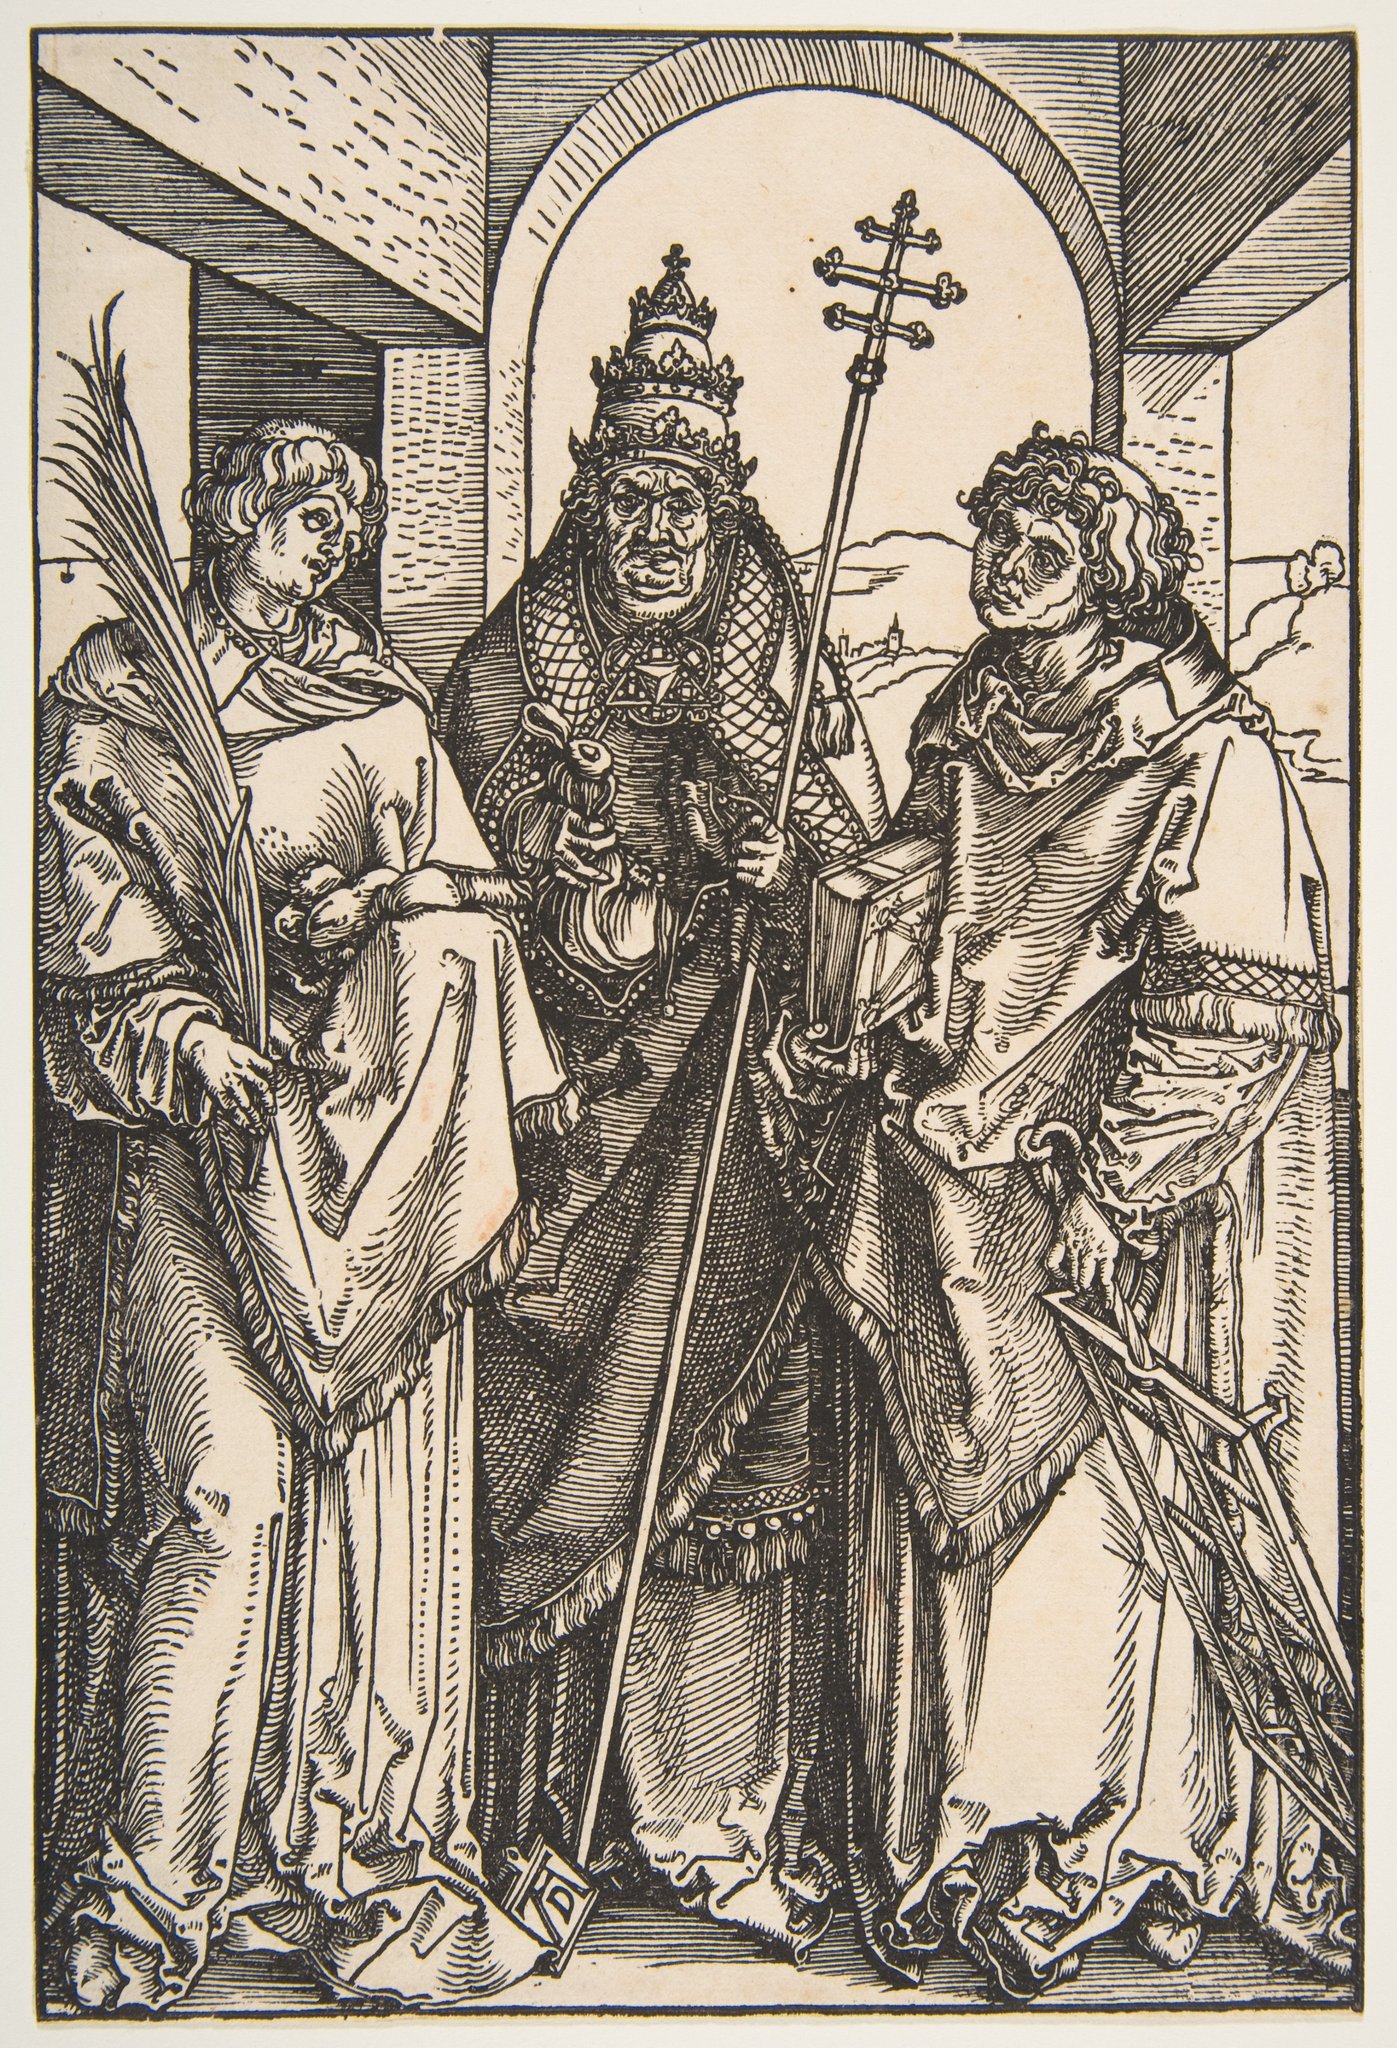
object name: print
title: Saints Stephen, Sixtus and Lawrence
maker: albrecht dürer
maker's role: artist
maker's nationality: german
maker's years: 1471-1528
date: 1504-1505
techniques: woodcut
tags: men,women,saint lawrence,saints